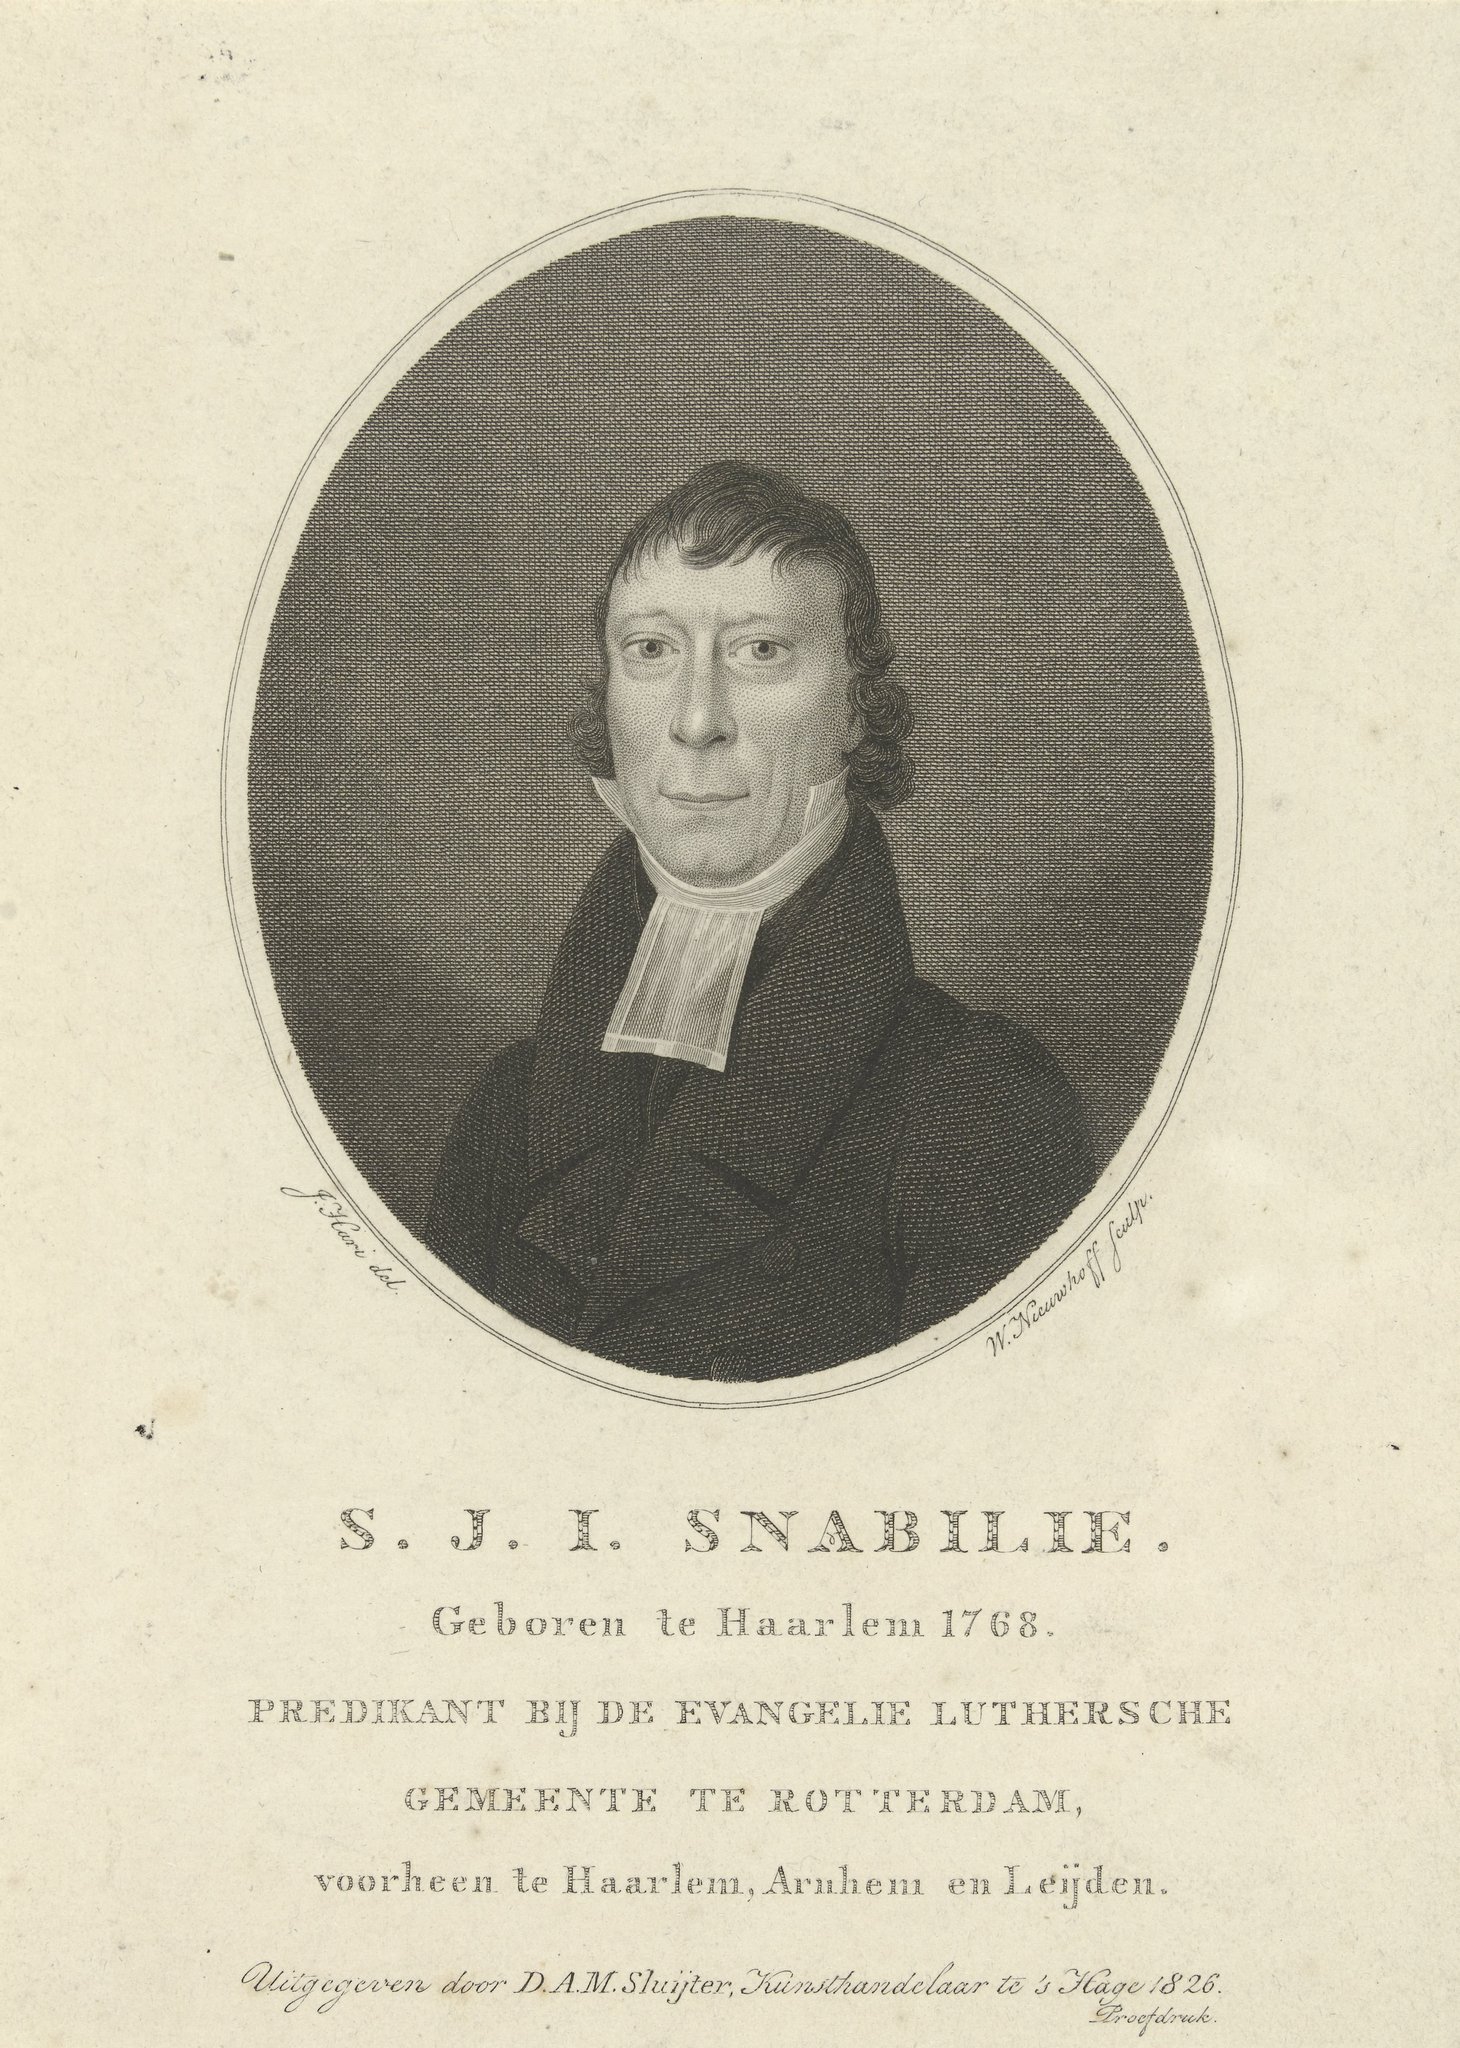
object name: print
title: S.J.I. Snabilie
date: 1826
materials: paper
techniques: engraving, etching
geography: the hague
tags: haarlem, rotterdam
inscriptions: collector's mark: Lugt 2228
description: Portret van S.J.I. Snabilie, Evangelisch Luthers predikant te Rotterdam, gekleed in zwarte jas met een witte bef. Buste naar links in ovaal. Onderaan in de marge een vierregelige tekst in het Nederlands.